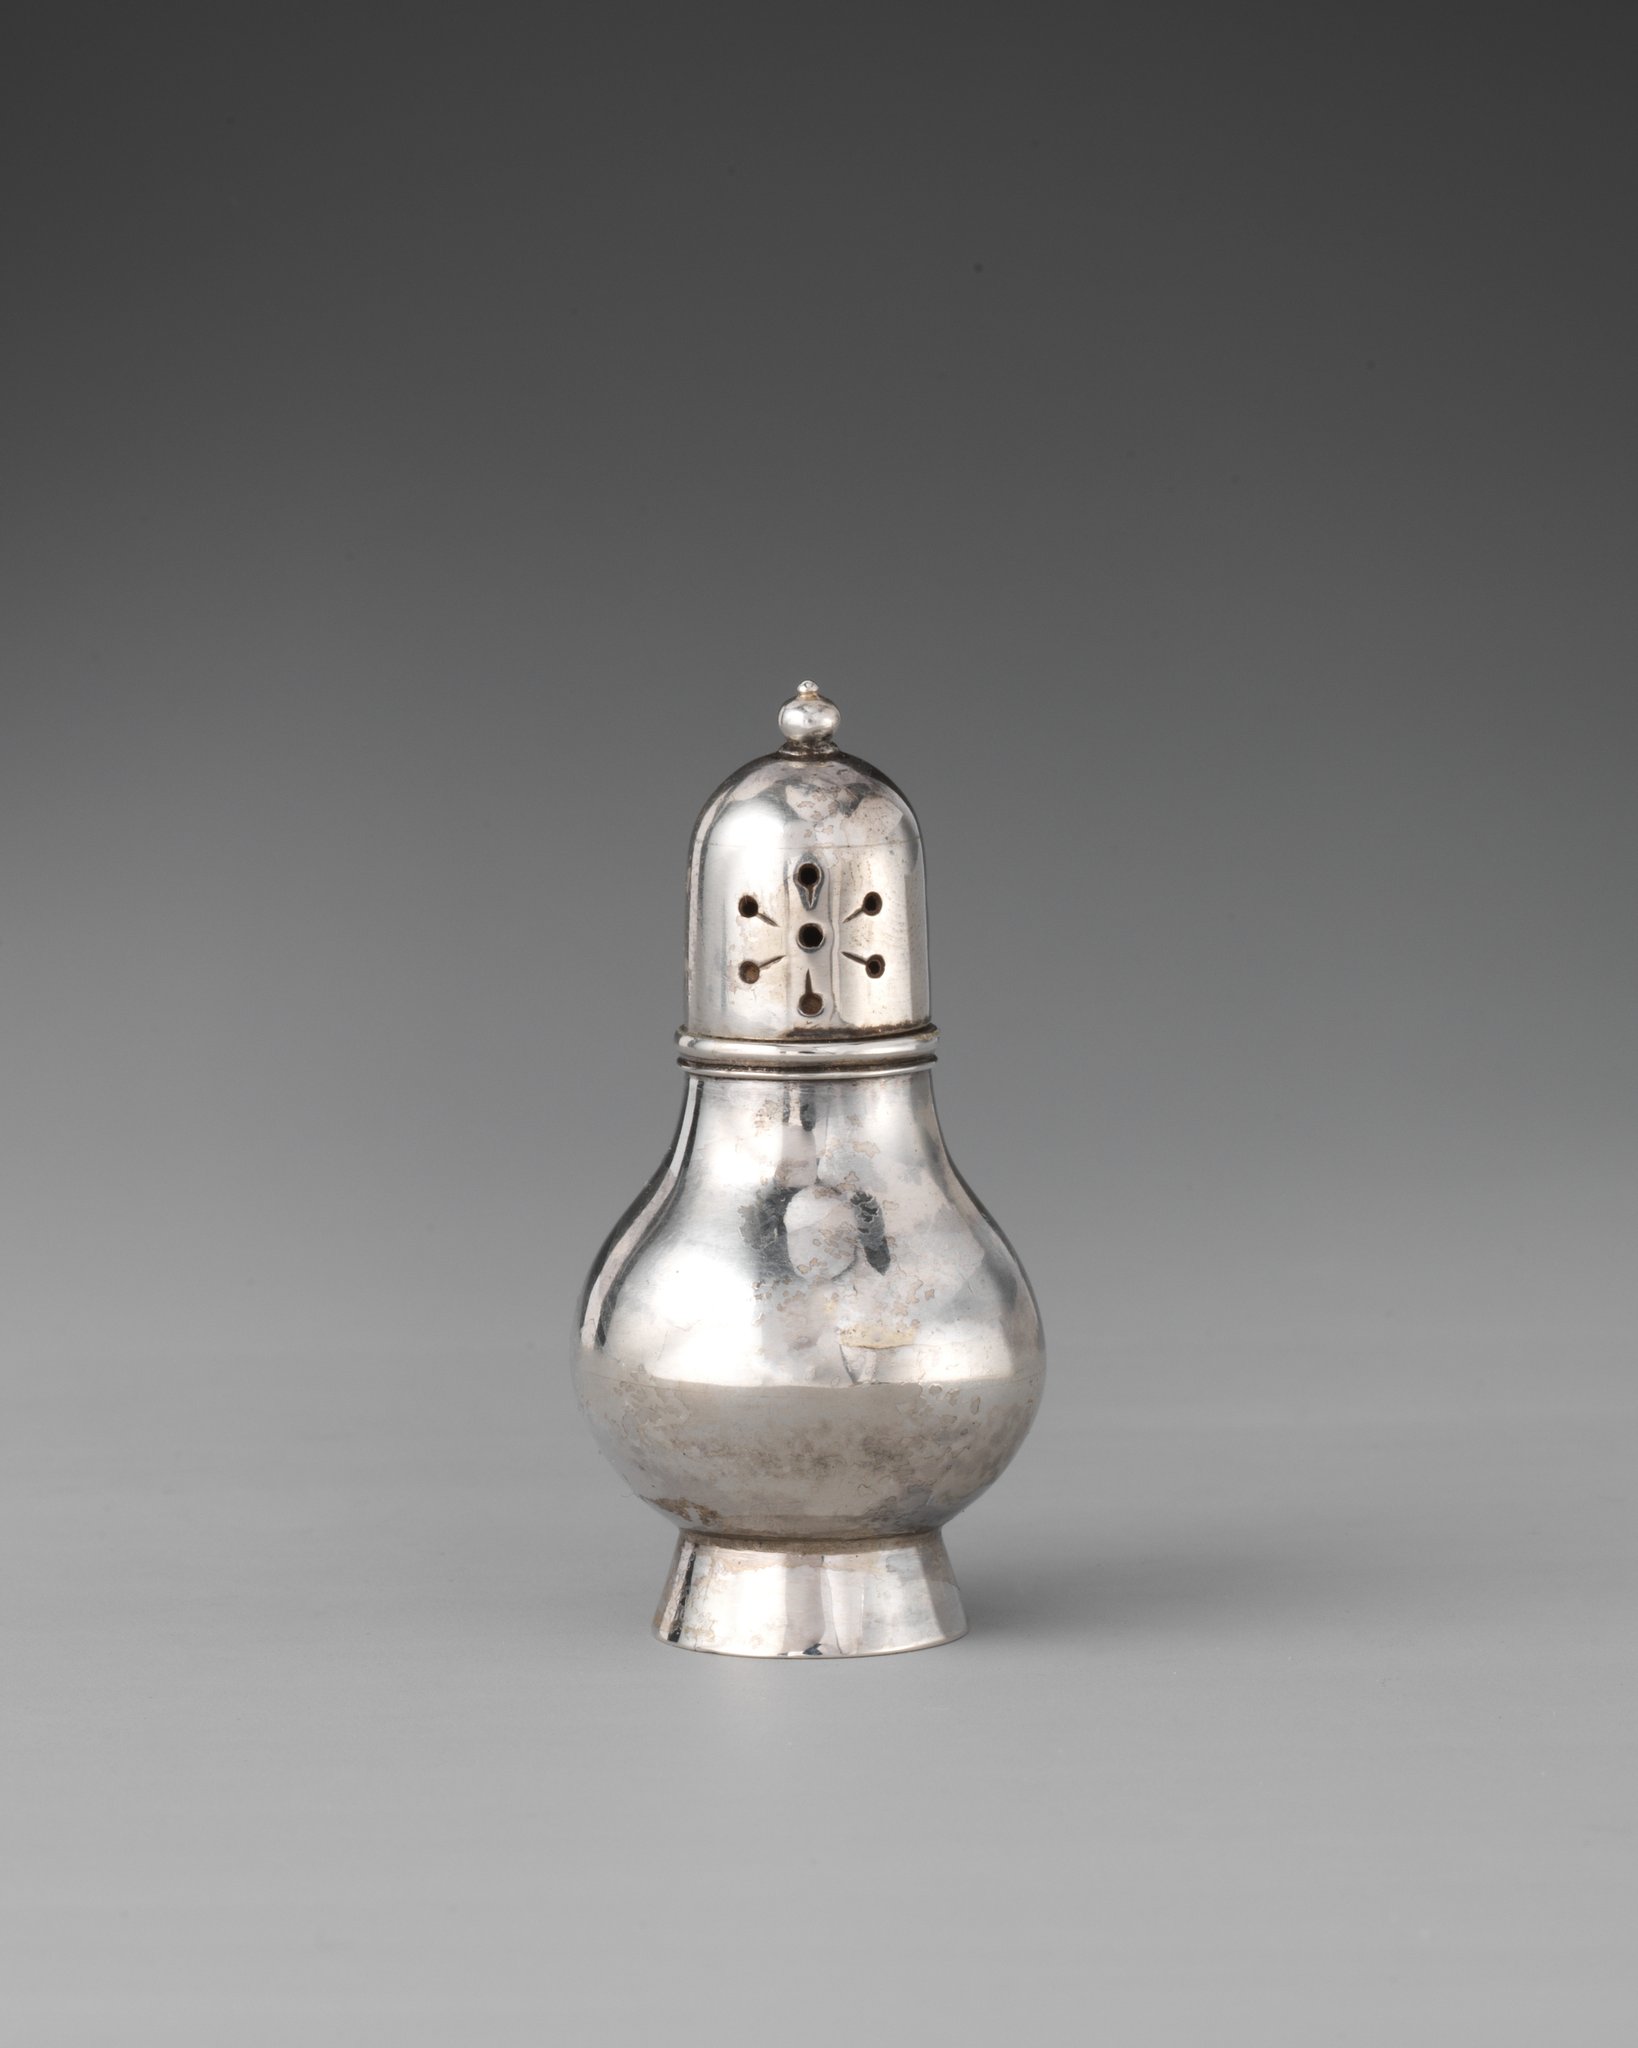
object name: caster with cover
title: Miniature caster with cover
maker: david clayton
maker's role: artist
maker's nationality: british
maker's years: 1659-1719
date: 1720-1723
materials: glass, silver